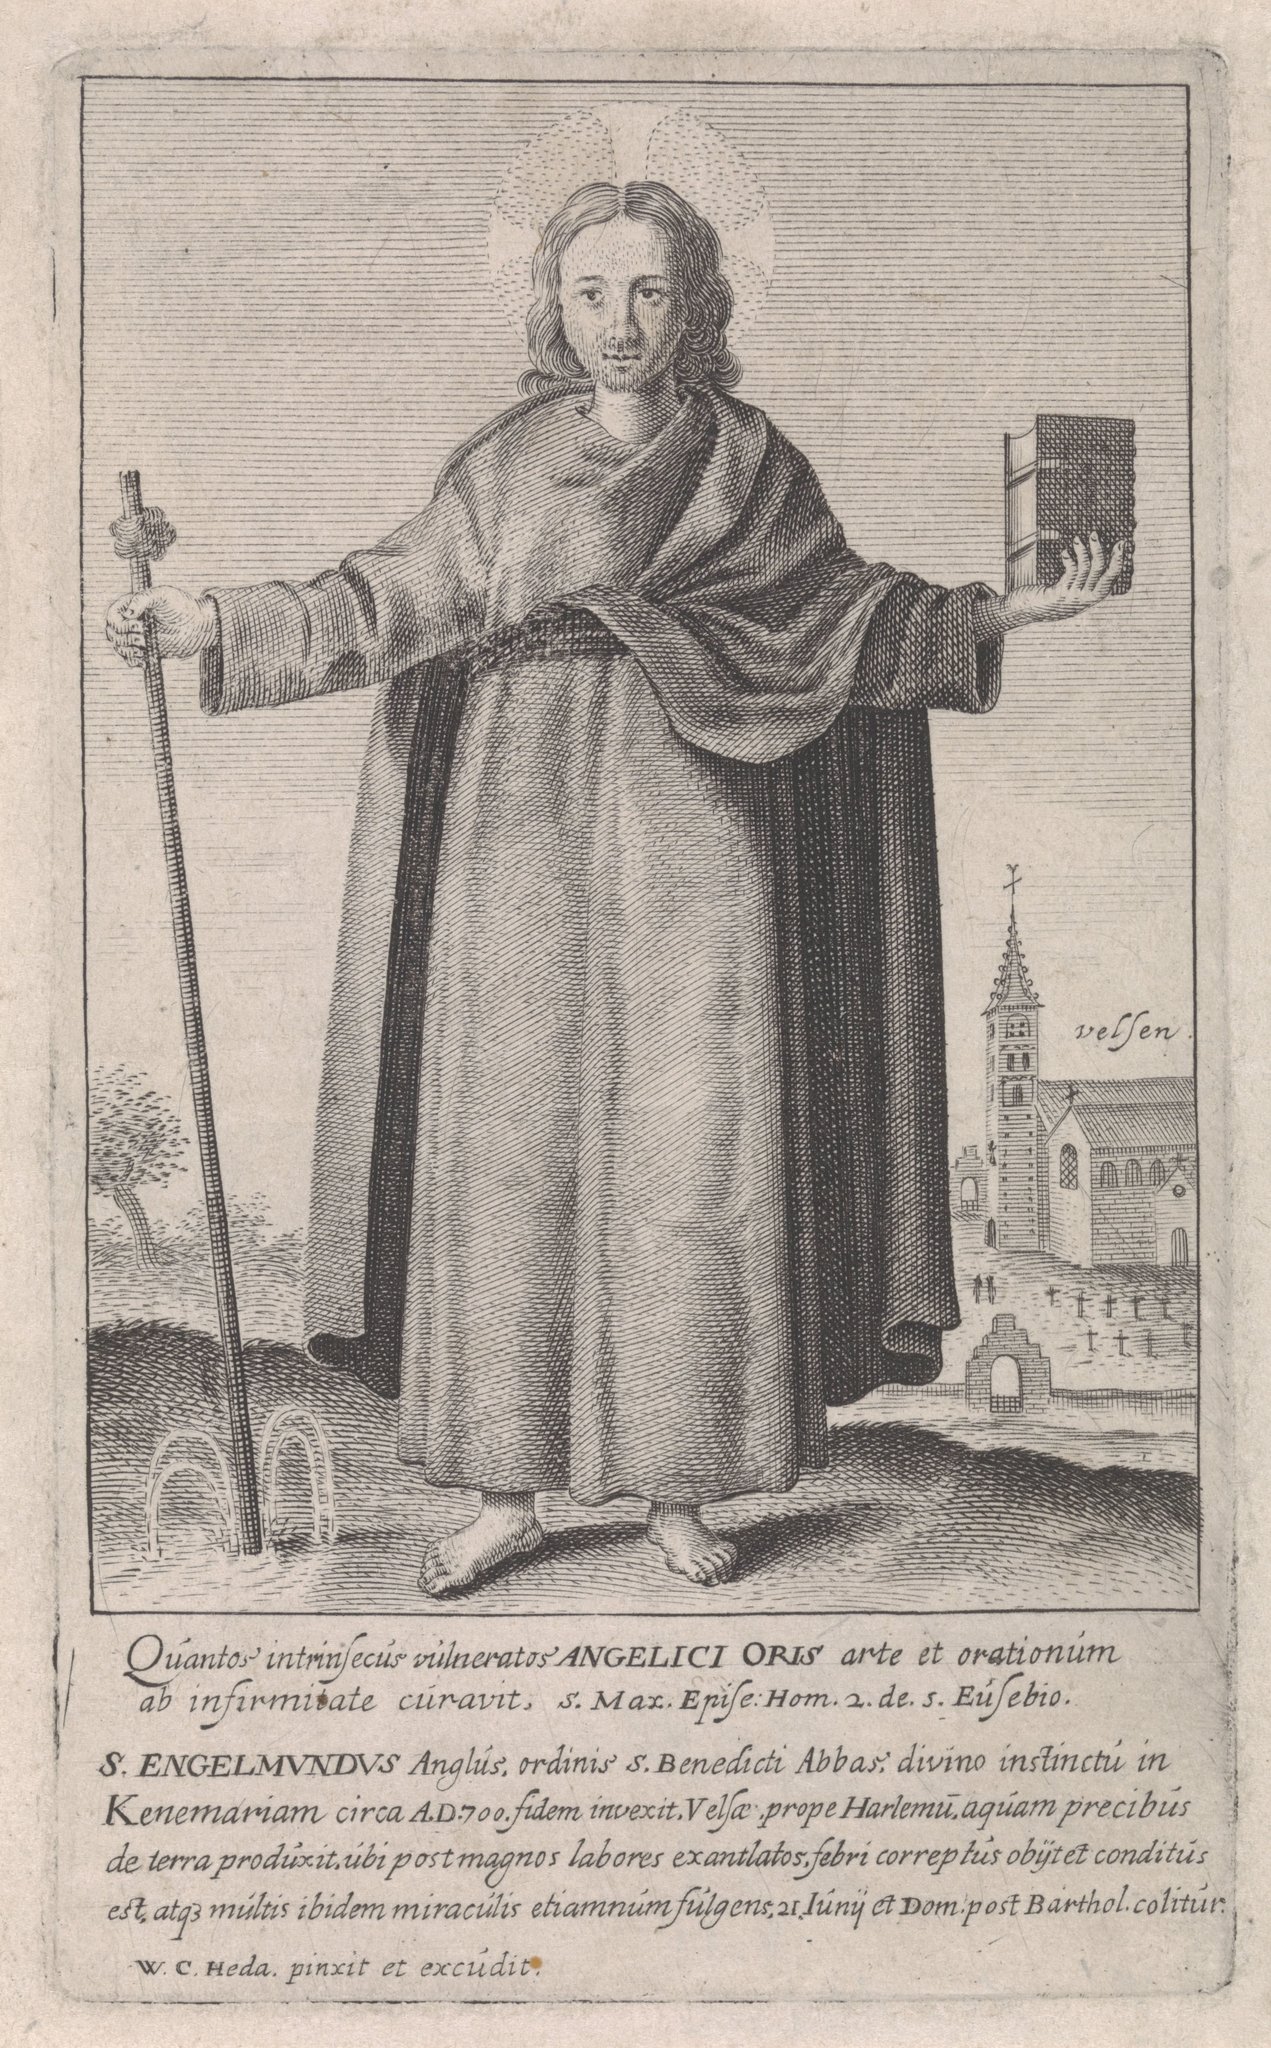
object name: print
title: H. Engelmundus van Engeland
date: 1607-1631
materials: paper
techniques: engraving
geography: haarlem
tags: male saints (with name)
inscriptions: collector's mark: Lugt 2228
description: De heilige abt Engelmundus van Engeland, staande in pij, met staf en bijbel. Aan zijn voeten ontspringt een bron. Op de achtergrond de kerk van Velsen.